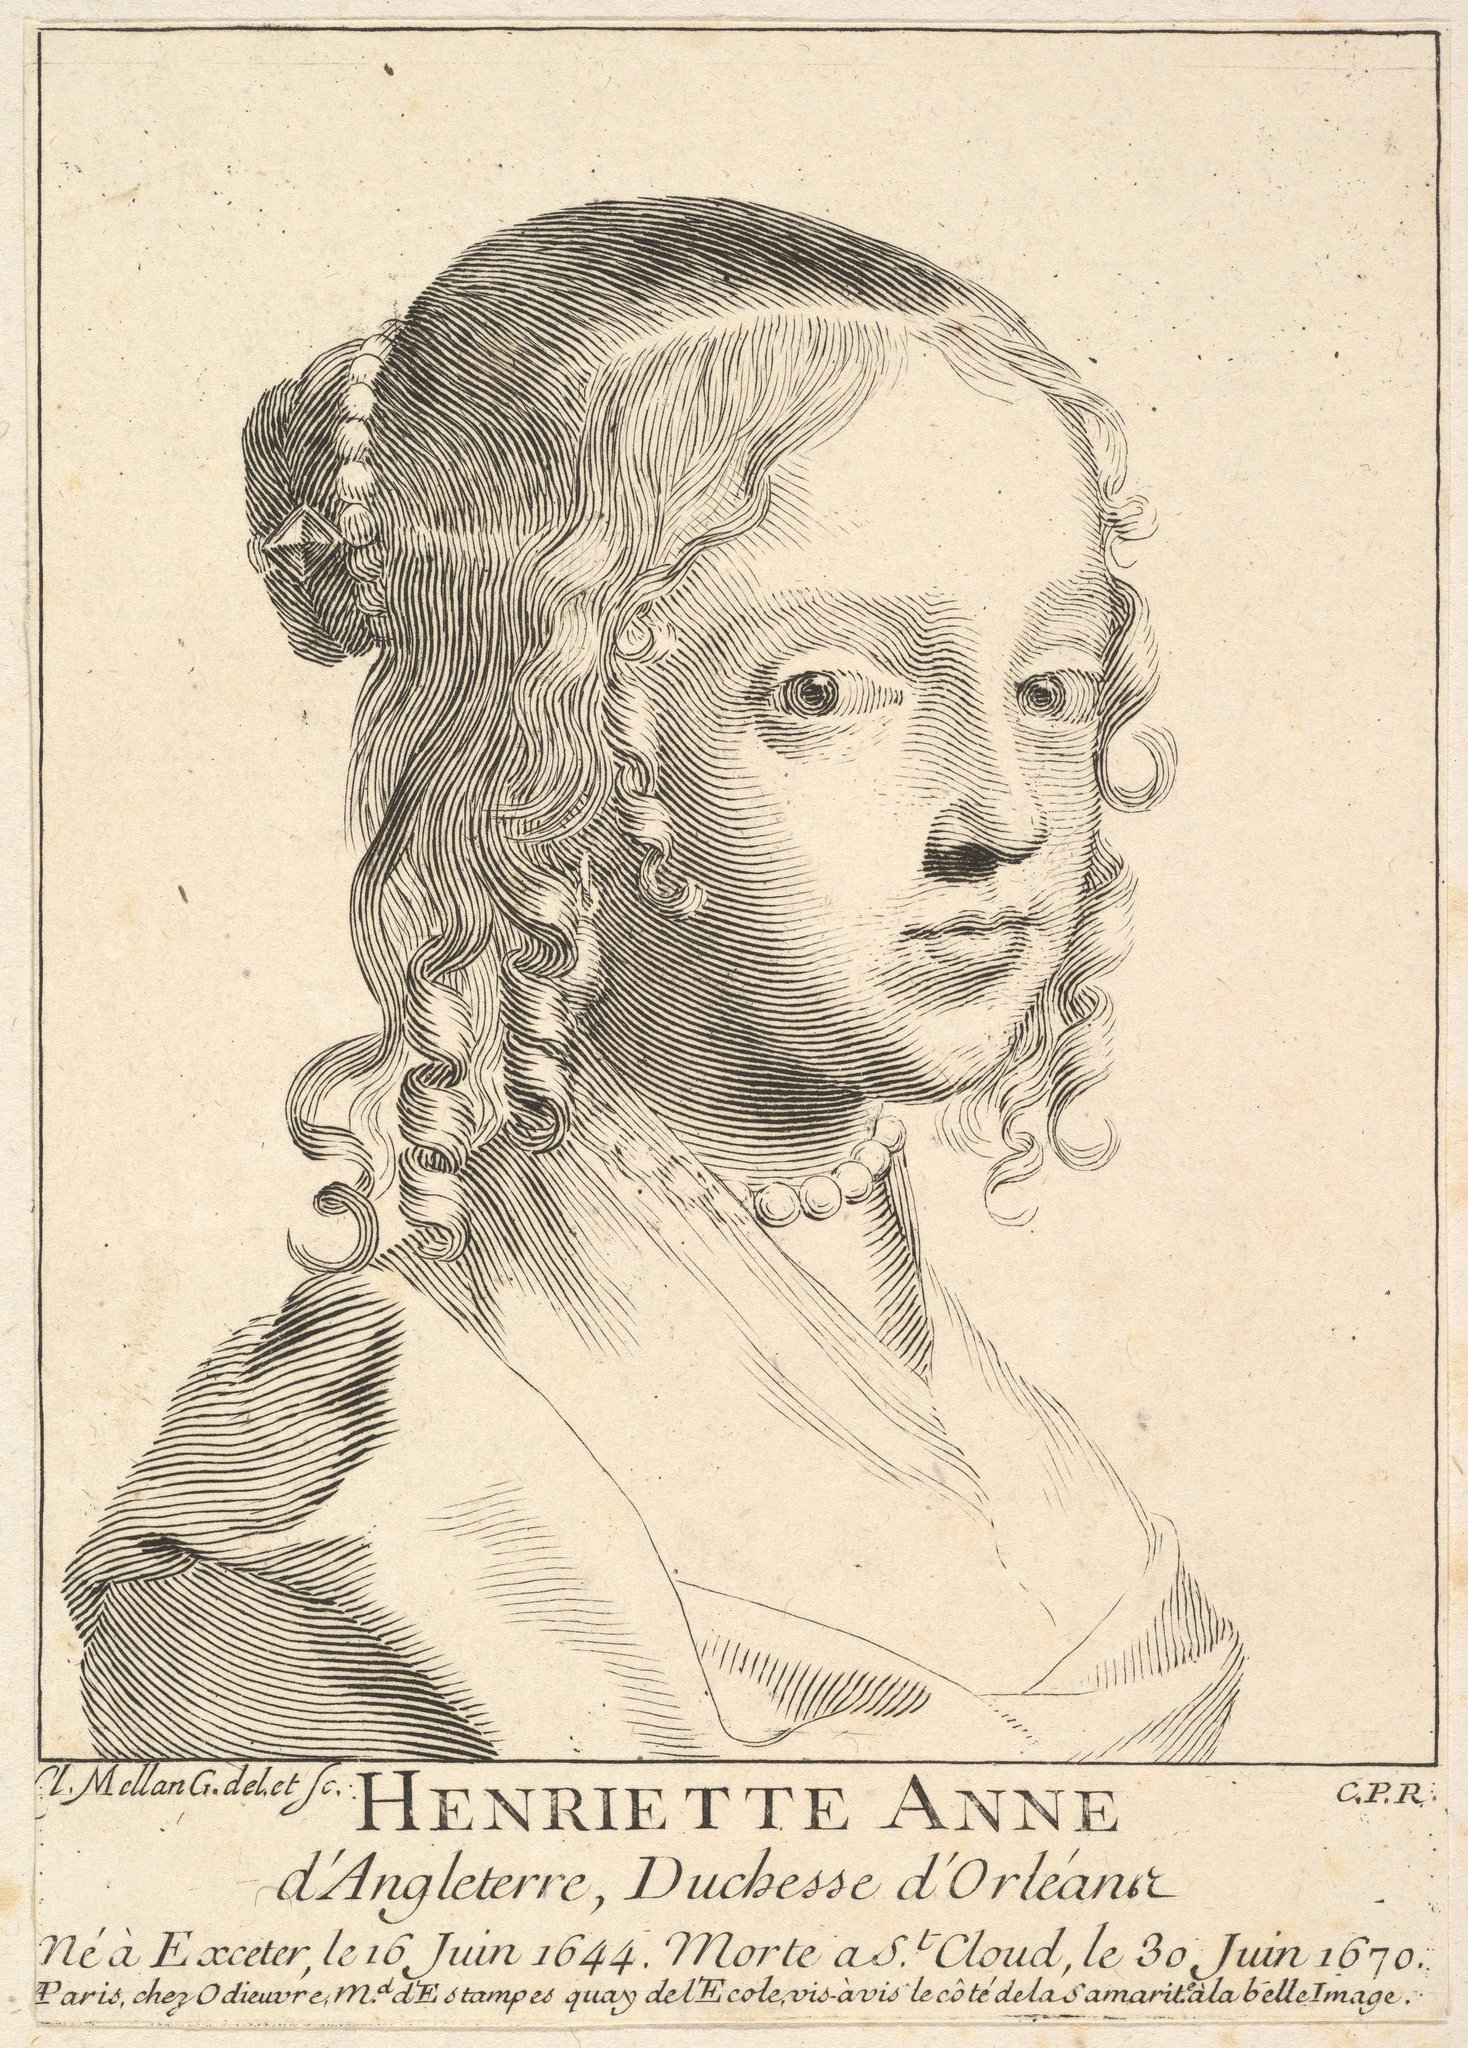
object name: print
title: Henriette-Anne d'Angleterre, duchesse d'Orléans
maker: claude mellan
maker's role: artist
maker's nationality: french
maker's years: 1598-1688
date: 1644-1670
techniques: engraving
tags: portraits,women